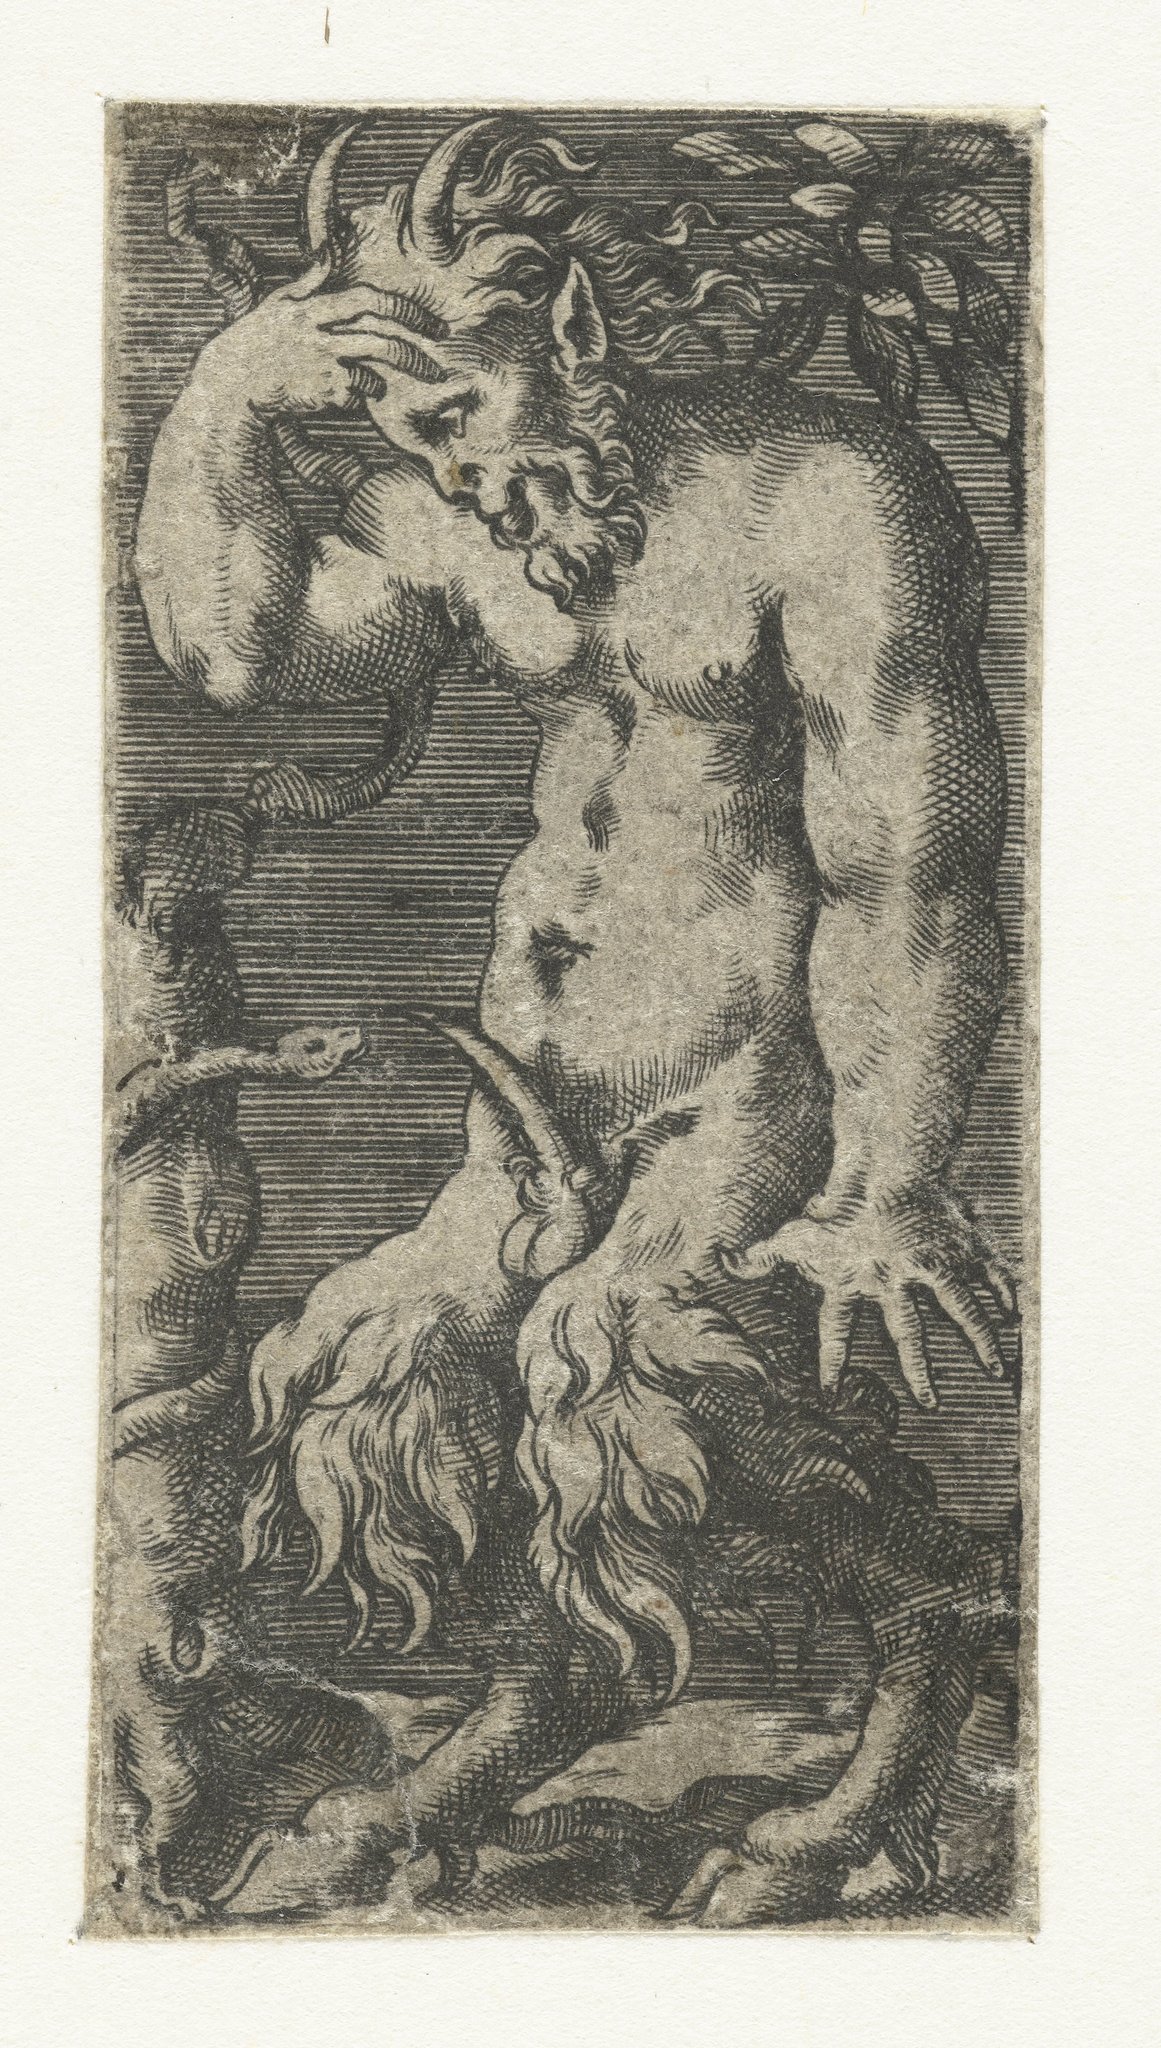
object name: print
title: Satyr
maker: Anonymous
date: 1500-1600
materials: paper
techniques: engraving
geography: germany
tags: satyr(s) (in general)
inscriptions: inscription: ‘find another Y (...)’, collector's mark: Lugt 2233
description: Een sater met zijn hand op zijn voorhoofd, kijkend naar een slang.